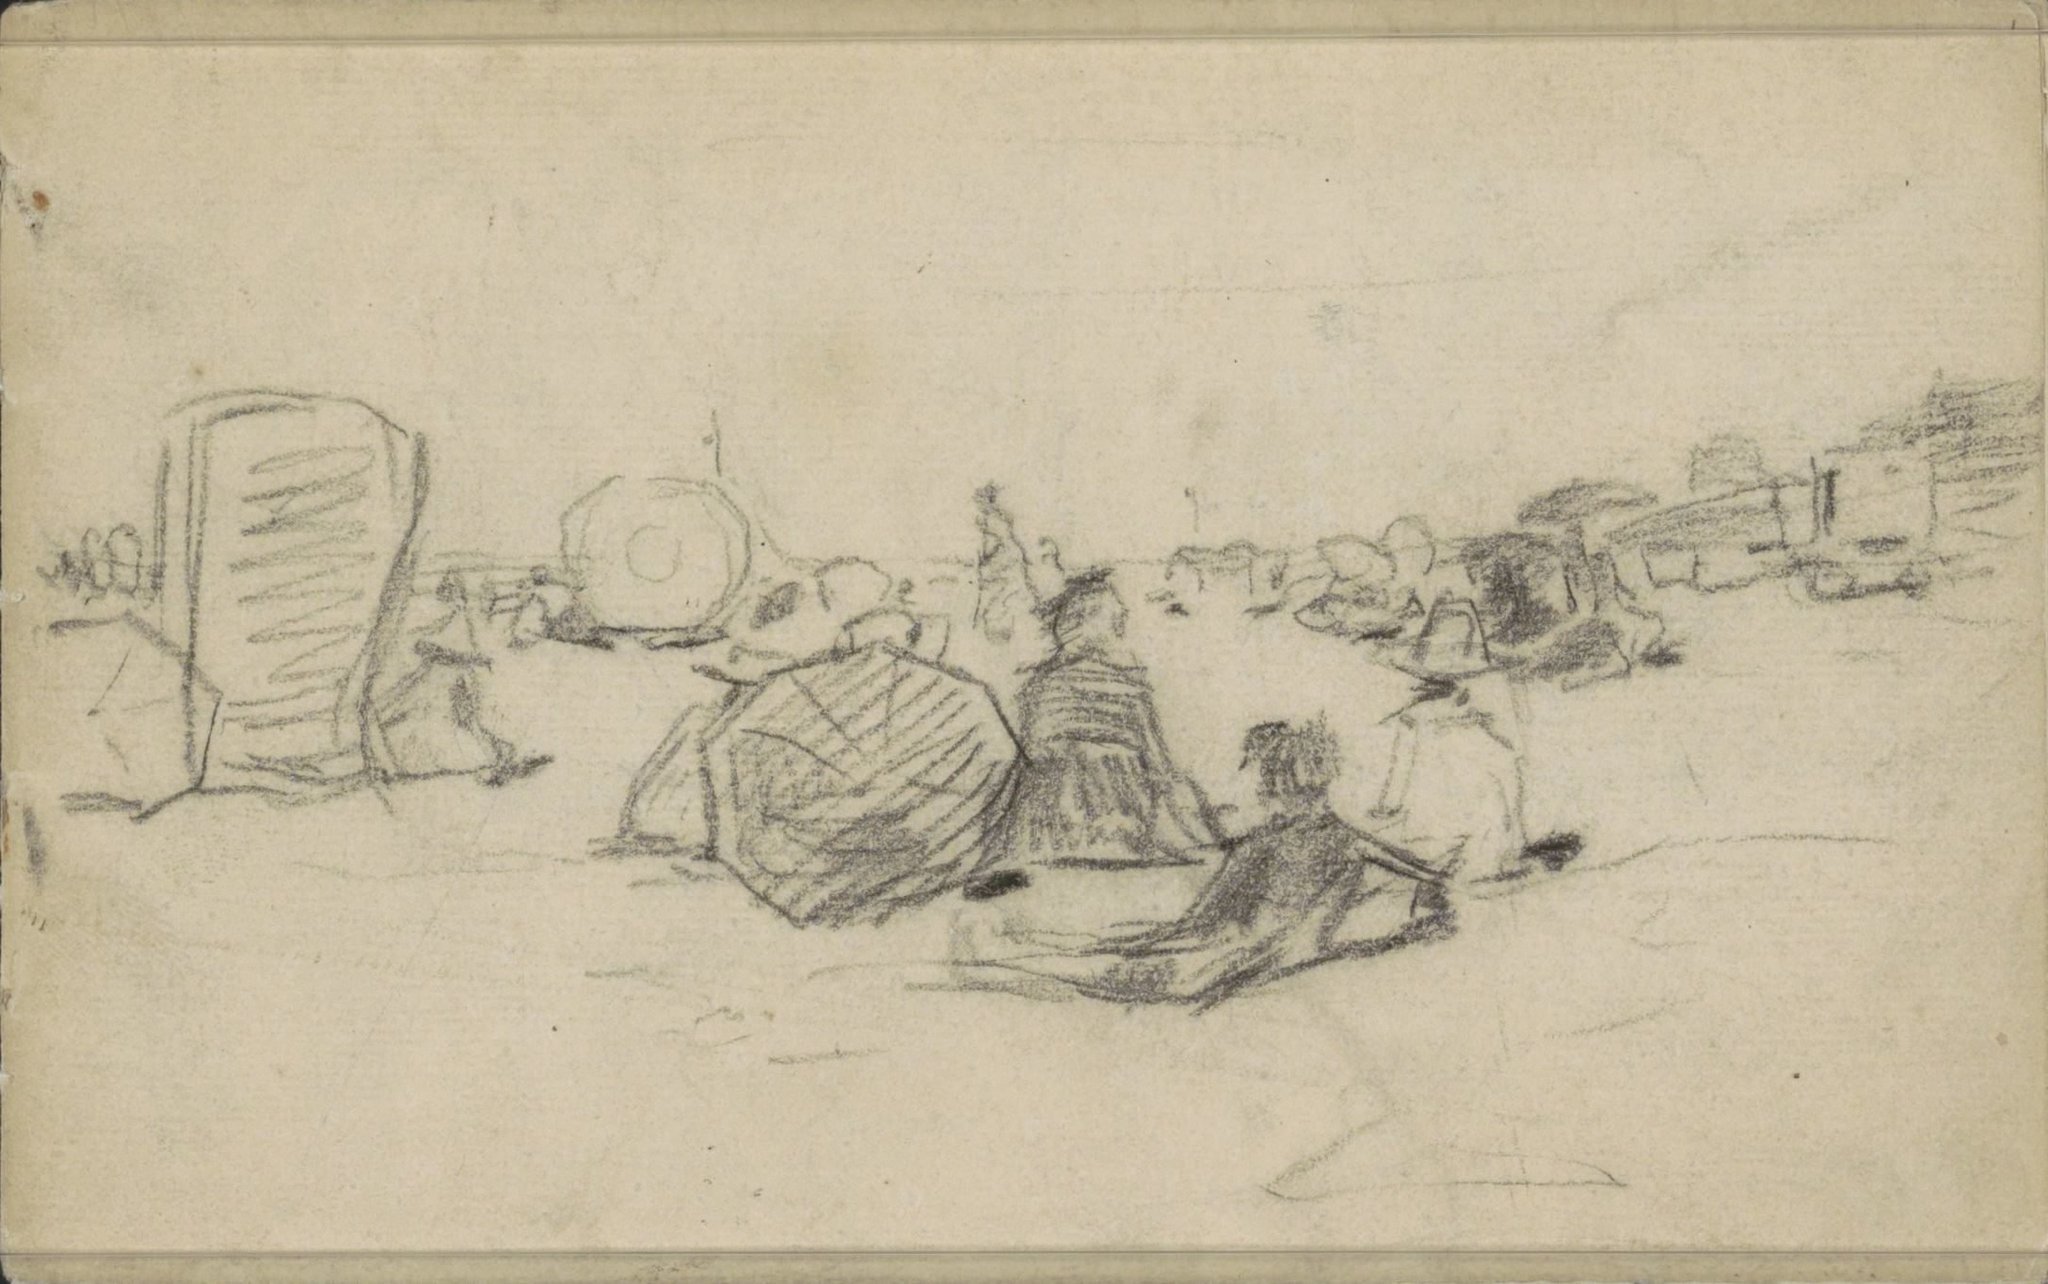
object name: sketchbook leaf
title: Recreërende figuren aan het strand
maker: marius bauer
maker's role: draughtsman, print maker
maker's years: 1867-1932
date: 1877-1885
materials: chalk, paper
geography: scheveningen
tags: beach (as place of recreation), sitting figure, chair, beach, parasol, sunshade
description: Pagina 1 uit een schetsboek met 8 bladen.